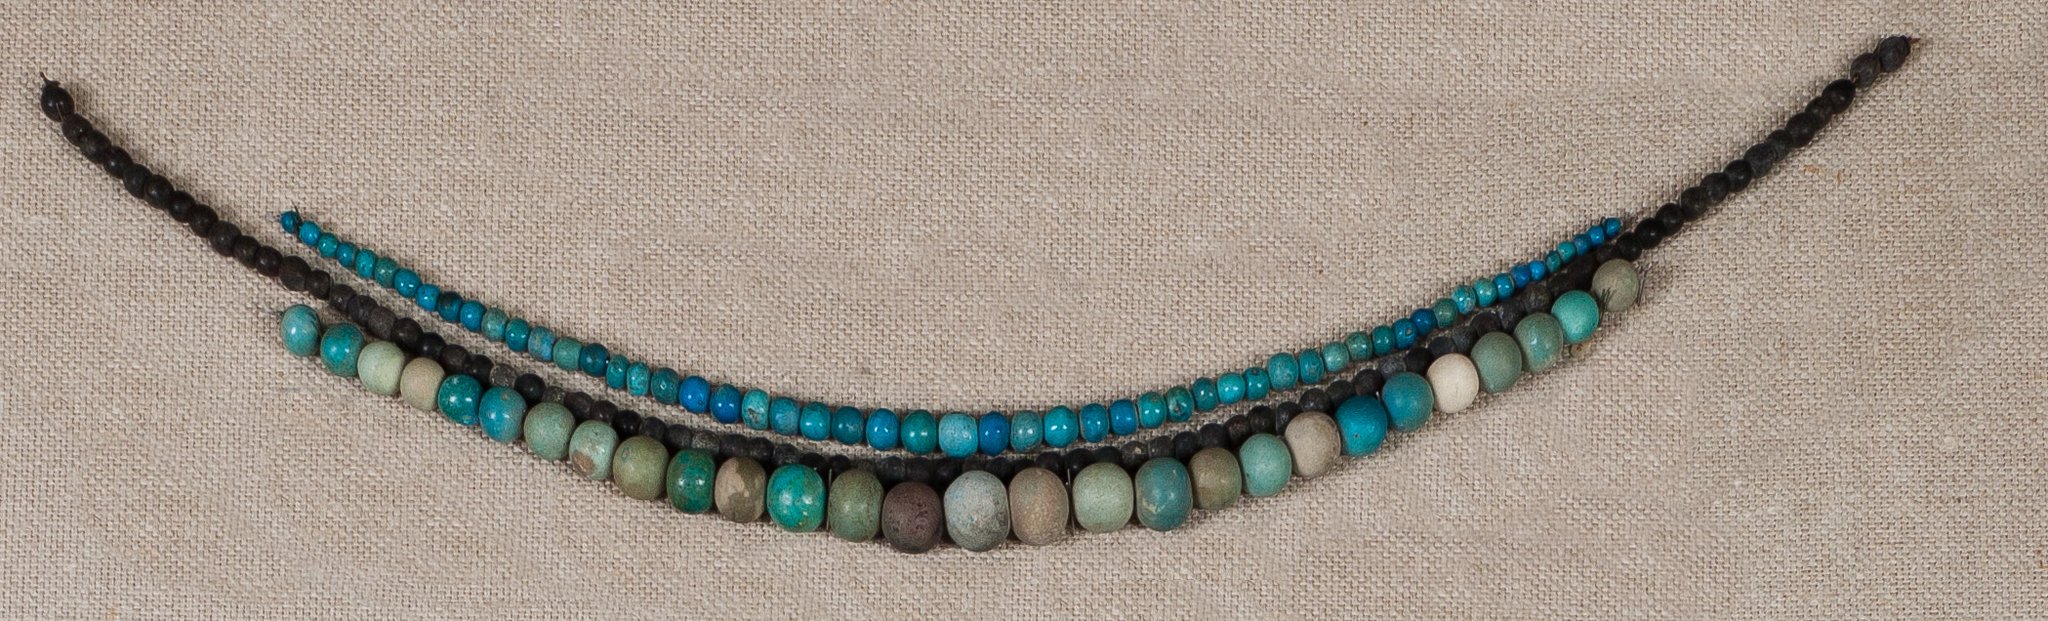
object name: necklace, bead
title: Necklace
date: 1981-1295 BCE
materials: faience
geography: egypt